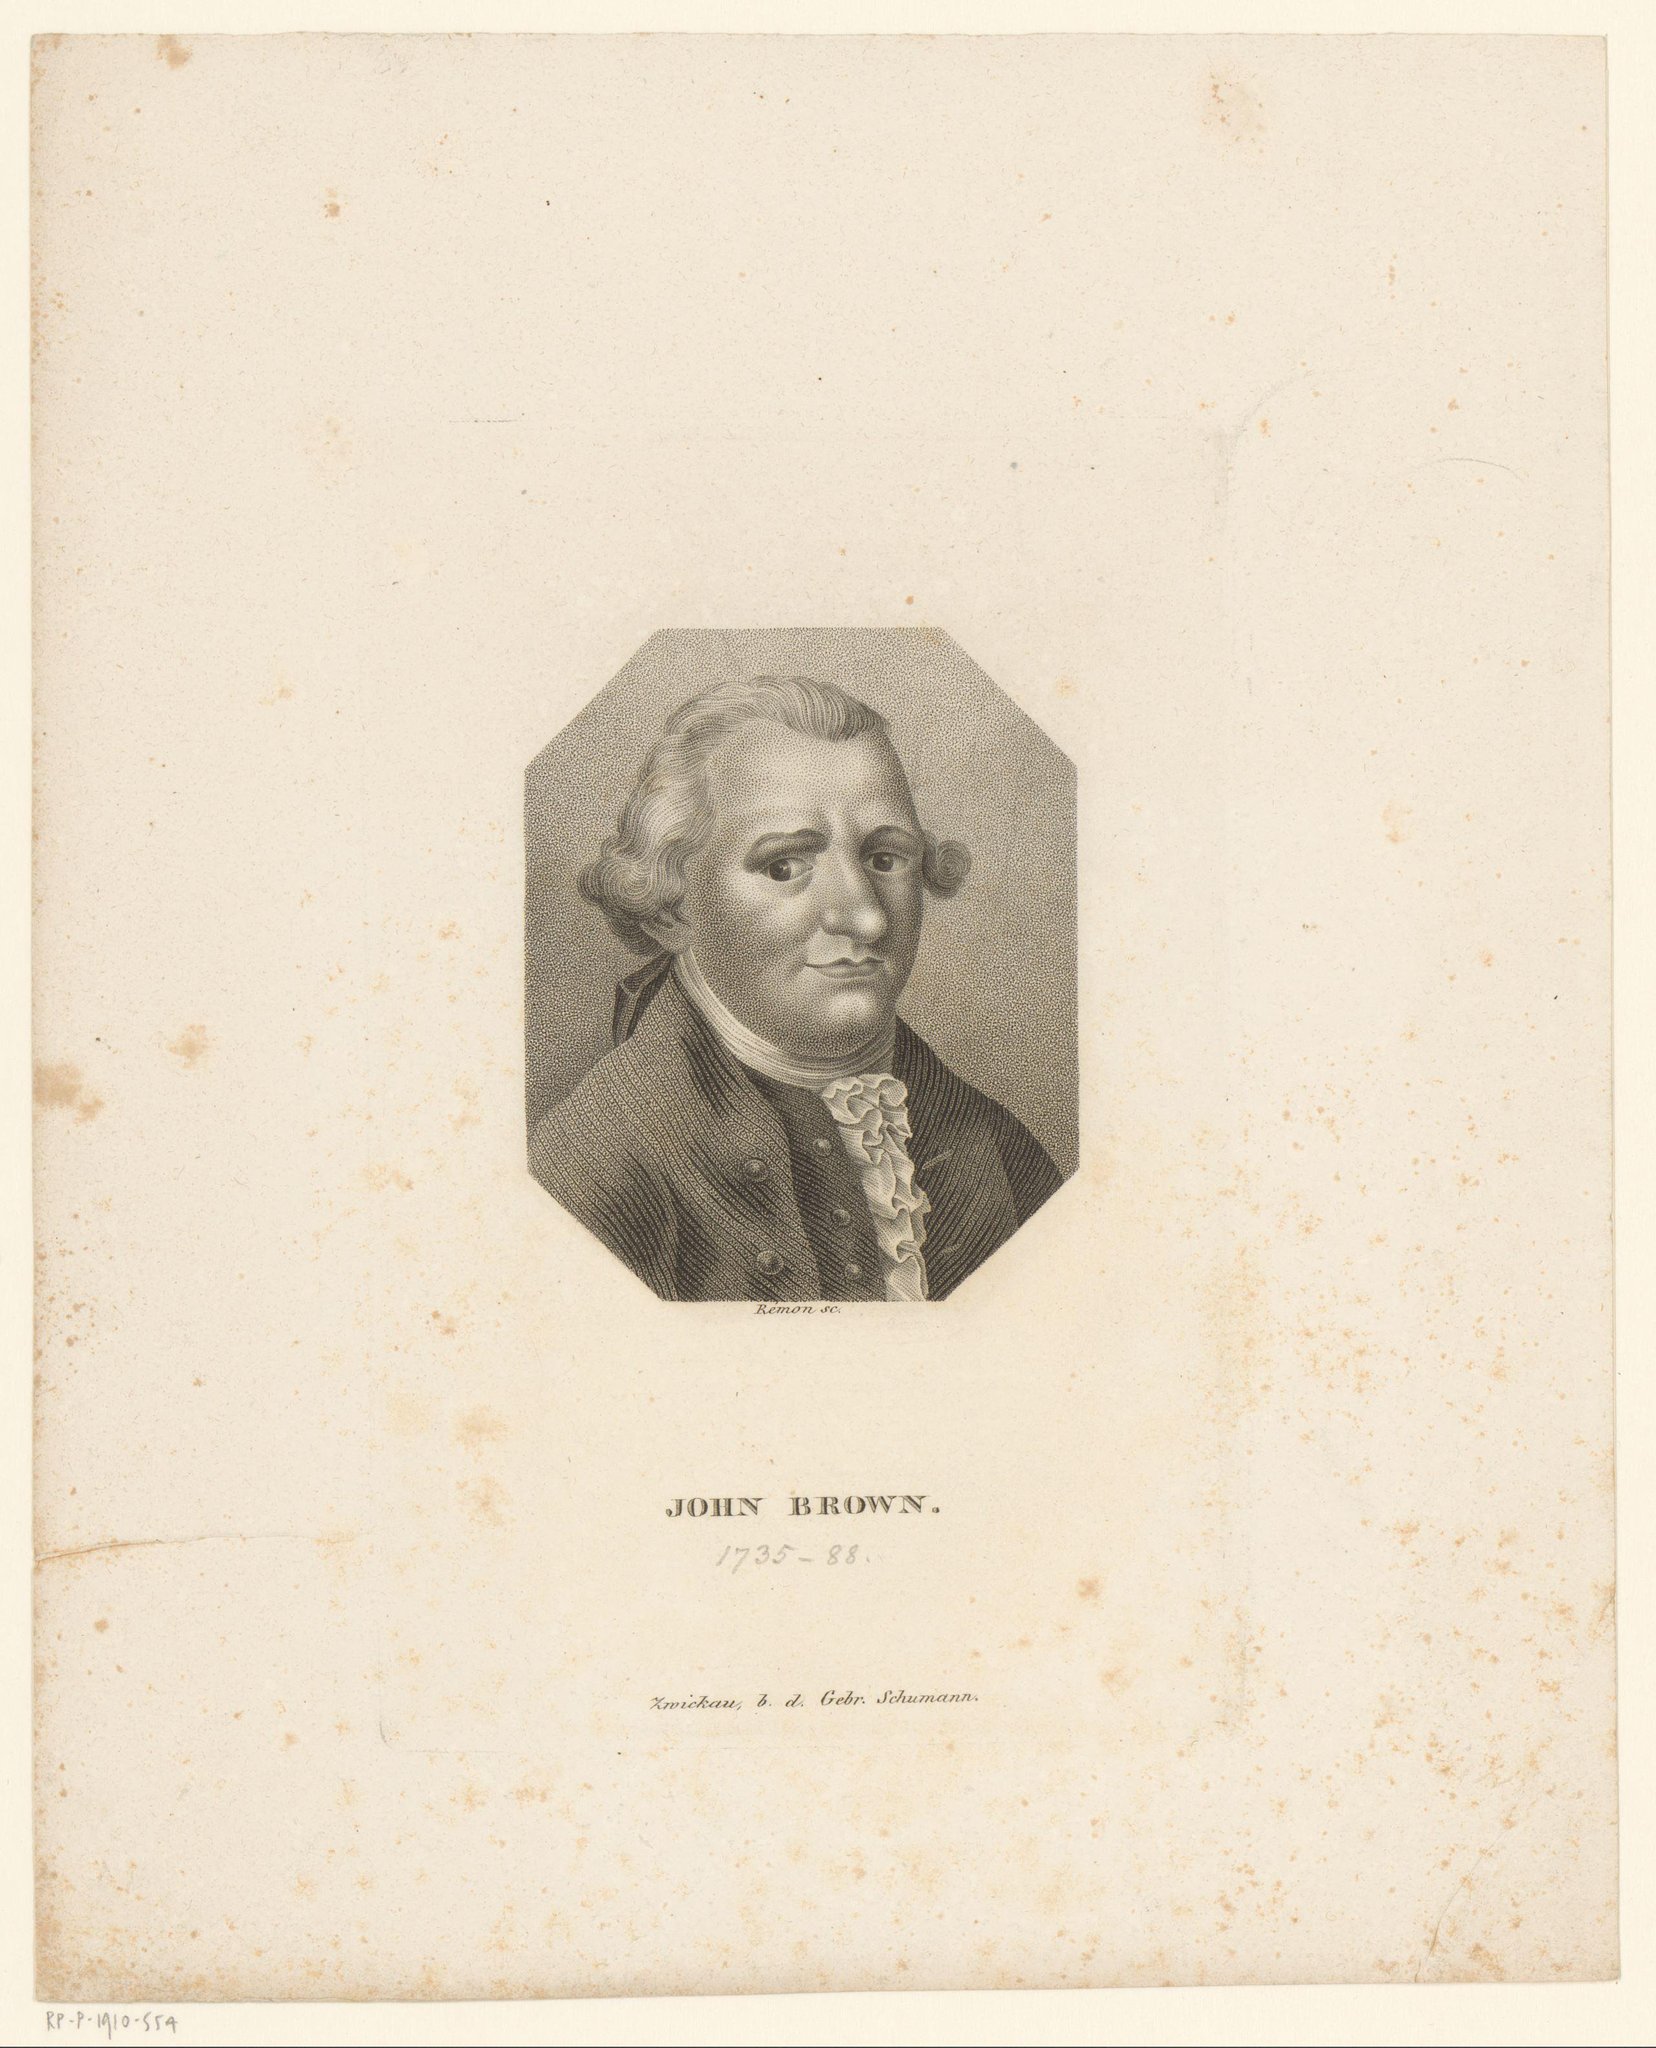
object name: print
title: John Brown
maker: j. rémon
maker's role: print maker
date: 1800-1899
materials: paper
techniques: stippling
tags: historical persons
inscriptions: collector's mark: Lugt 2228, date